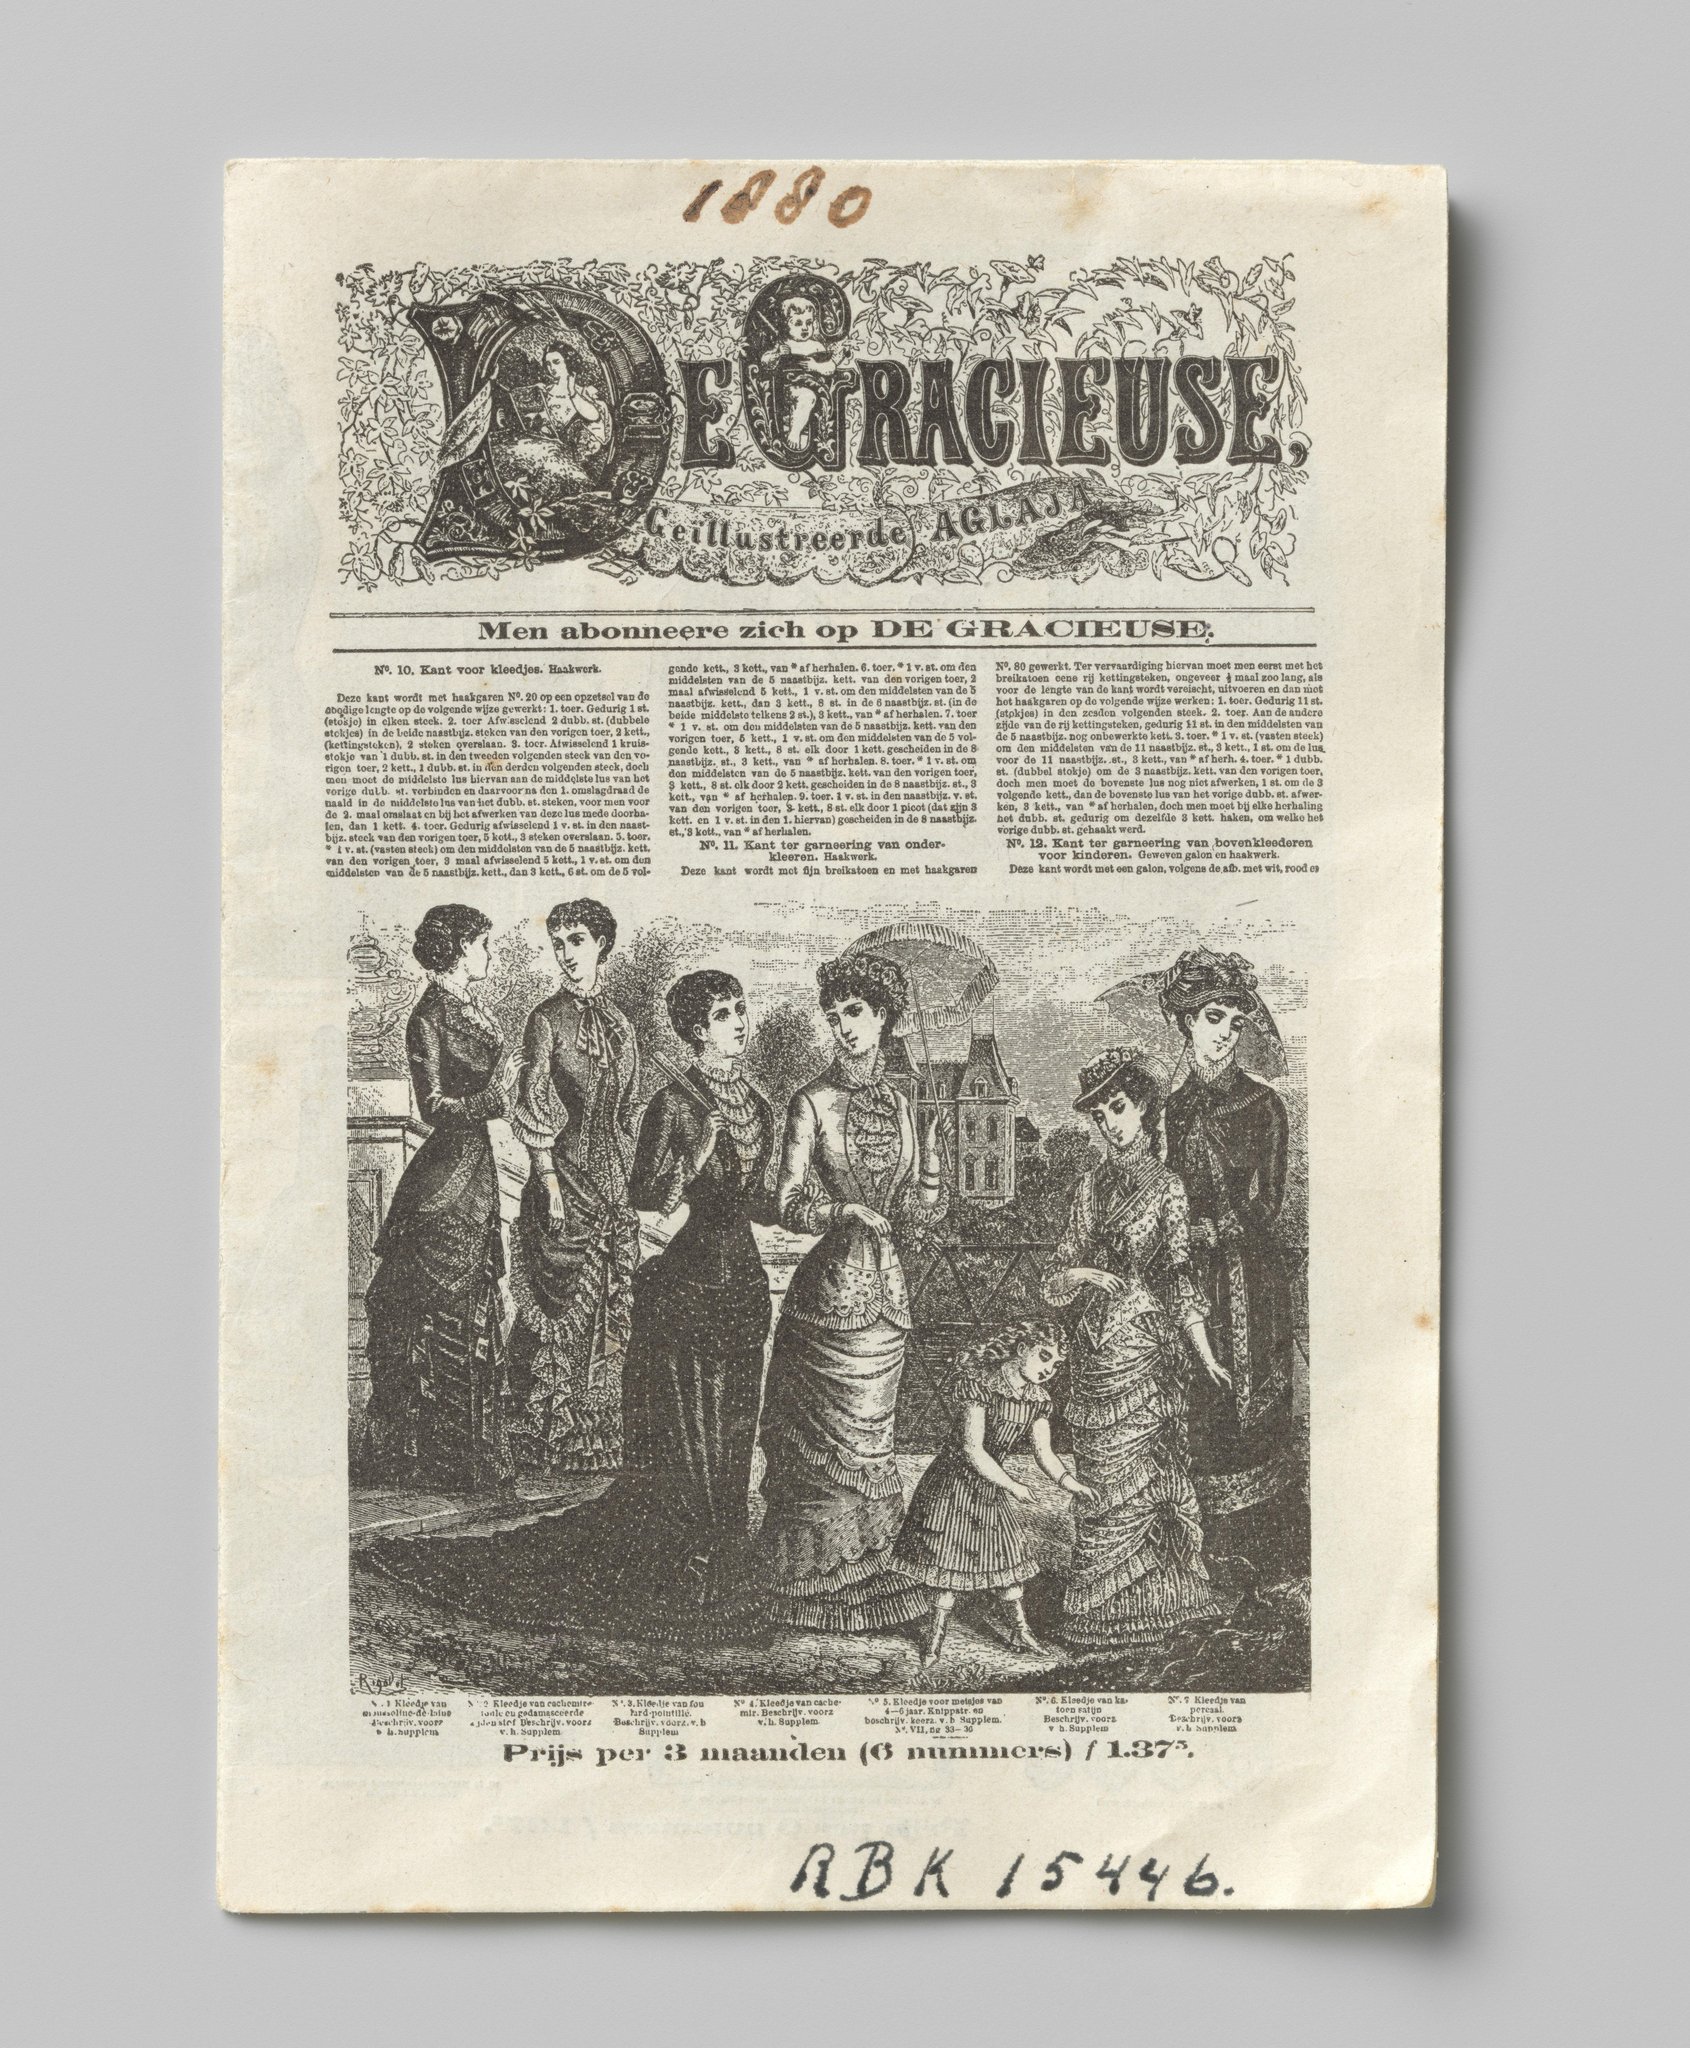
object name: magazine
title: Tijdschrift De Gracieuze, miniatuur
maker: Anonymous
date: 1880-1890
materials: paper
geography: netherlands